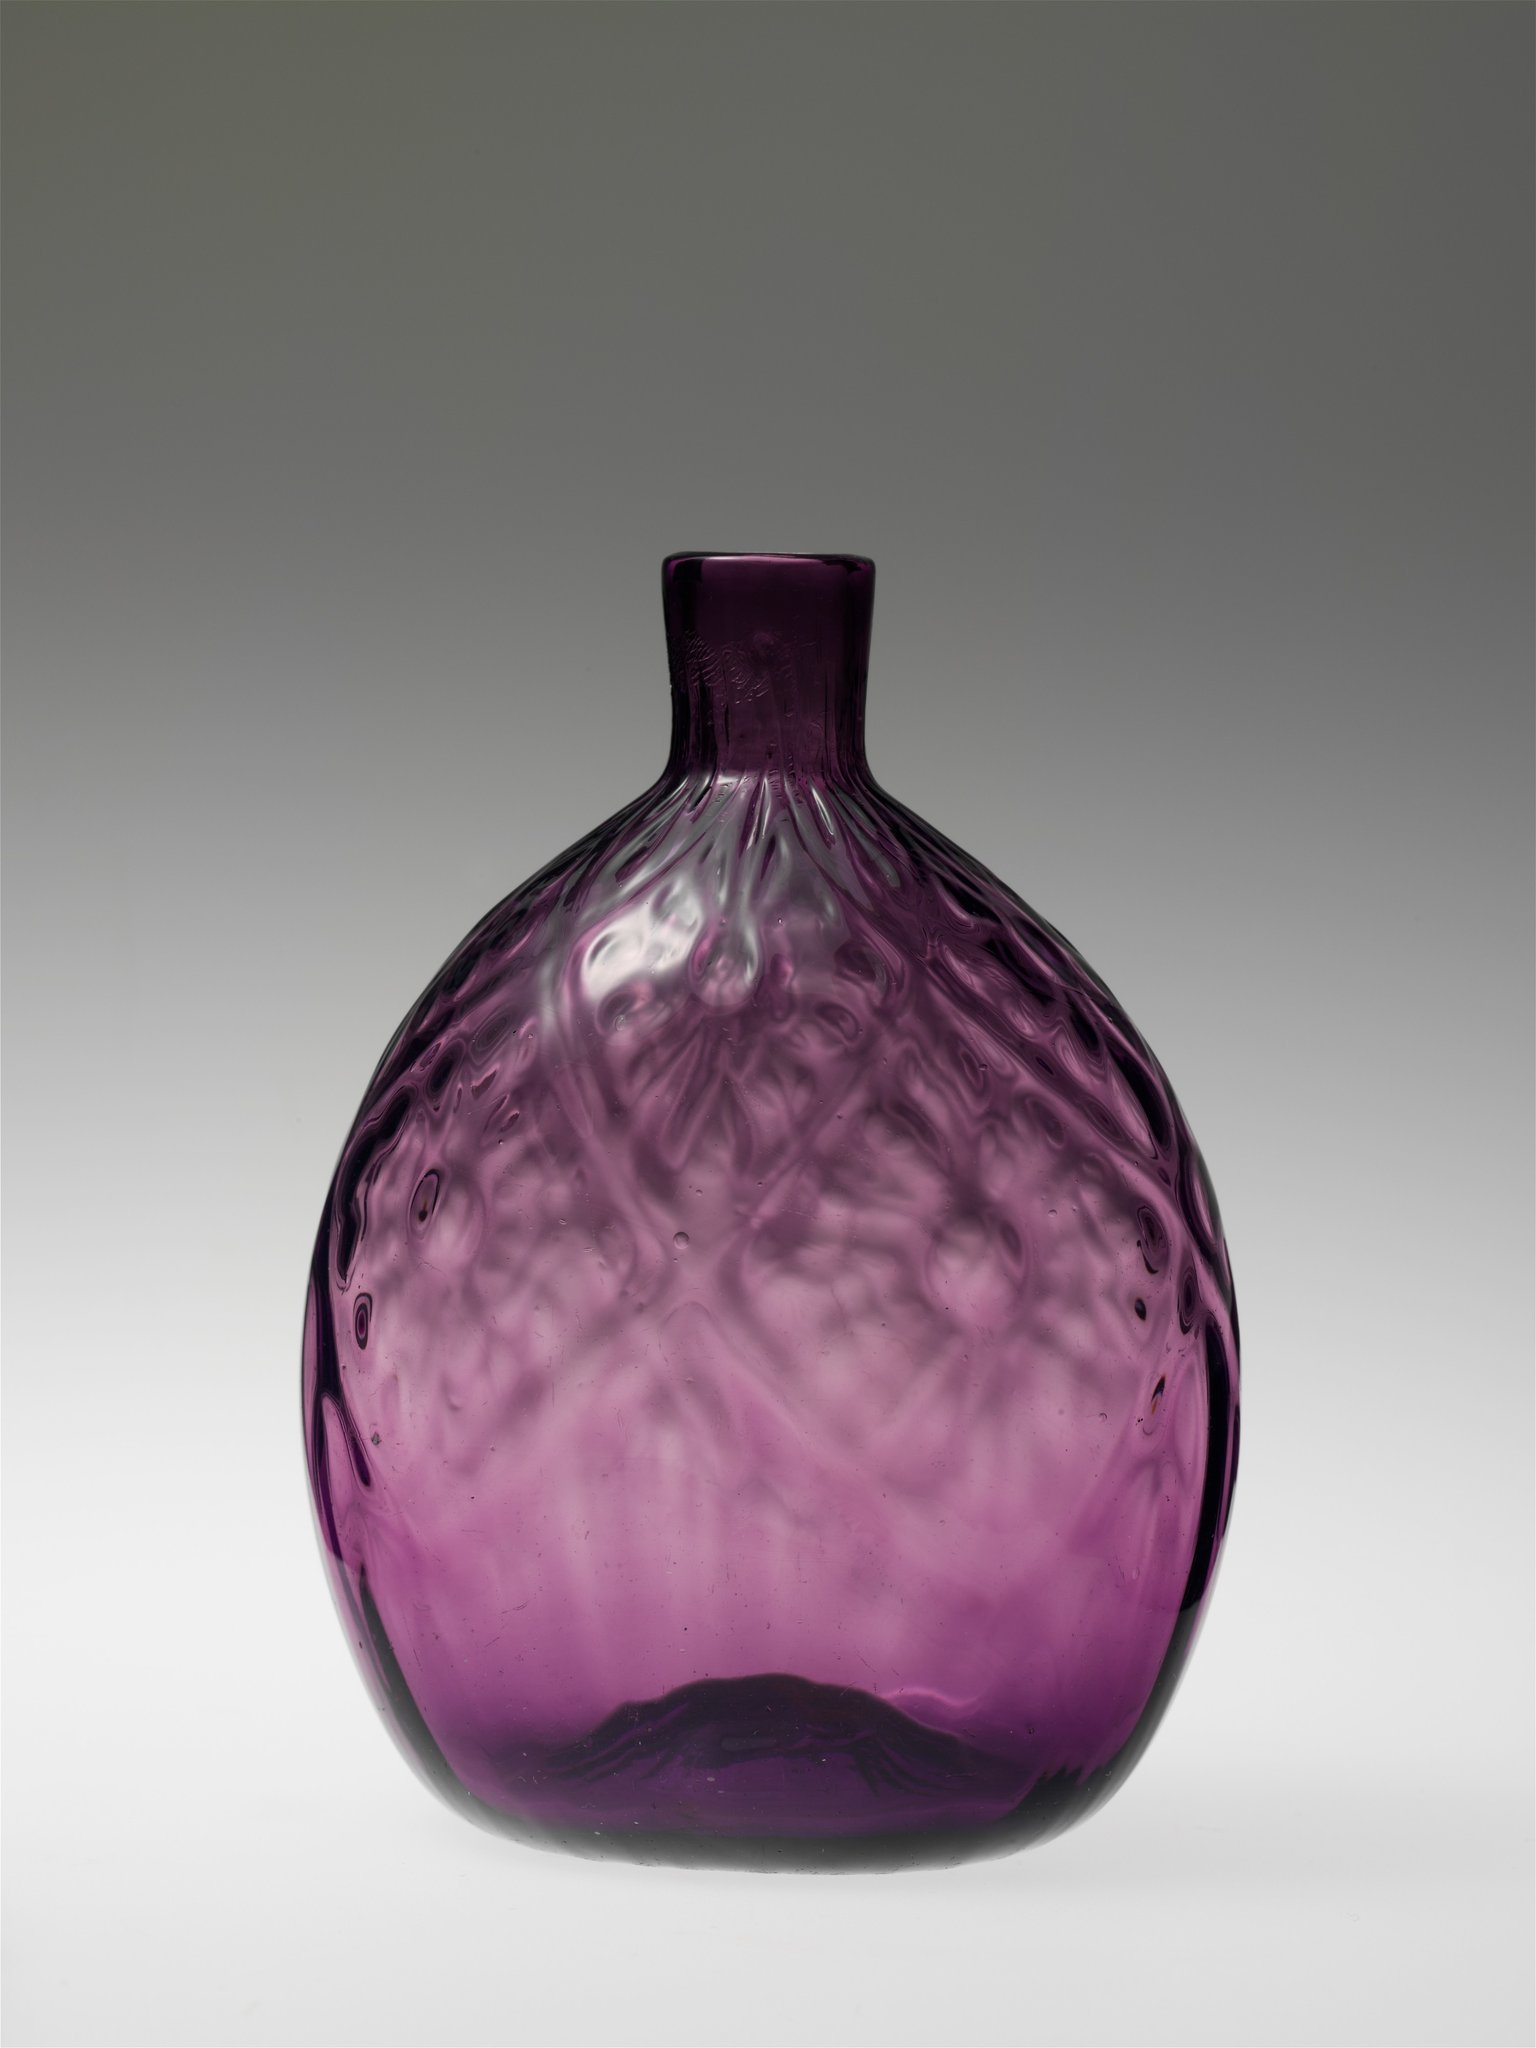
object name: pocket bottle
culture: american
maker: american flint glass manufactory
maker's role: maker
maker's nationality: american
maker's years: 1764-1774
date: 1769-1774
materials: glass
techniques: glassblowing, molding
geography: united states